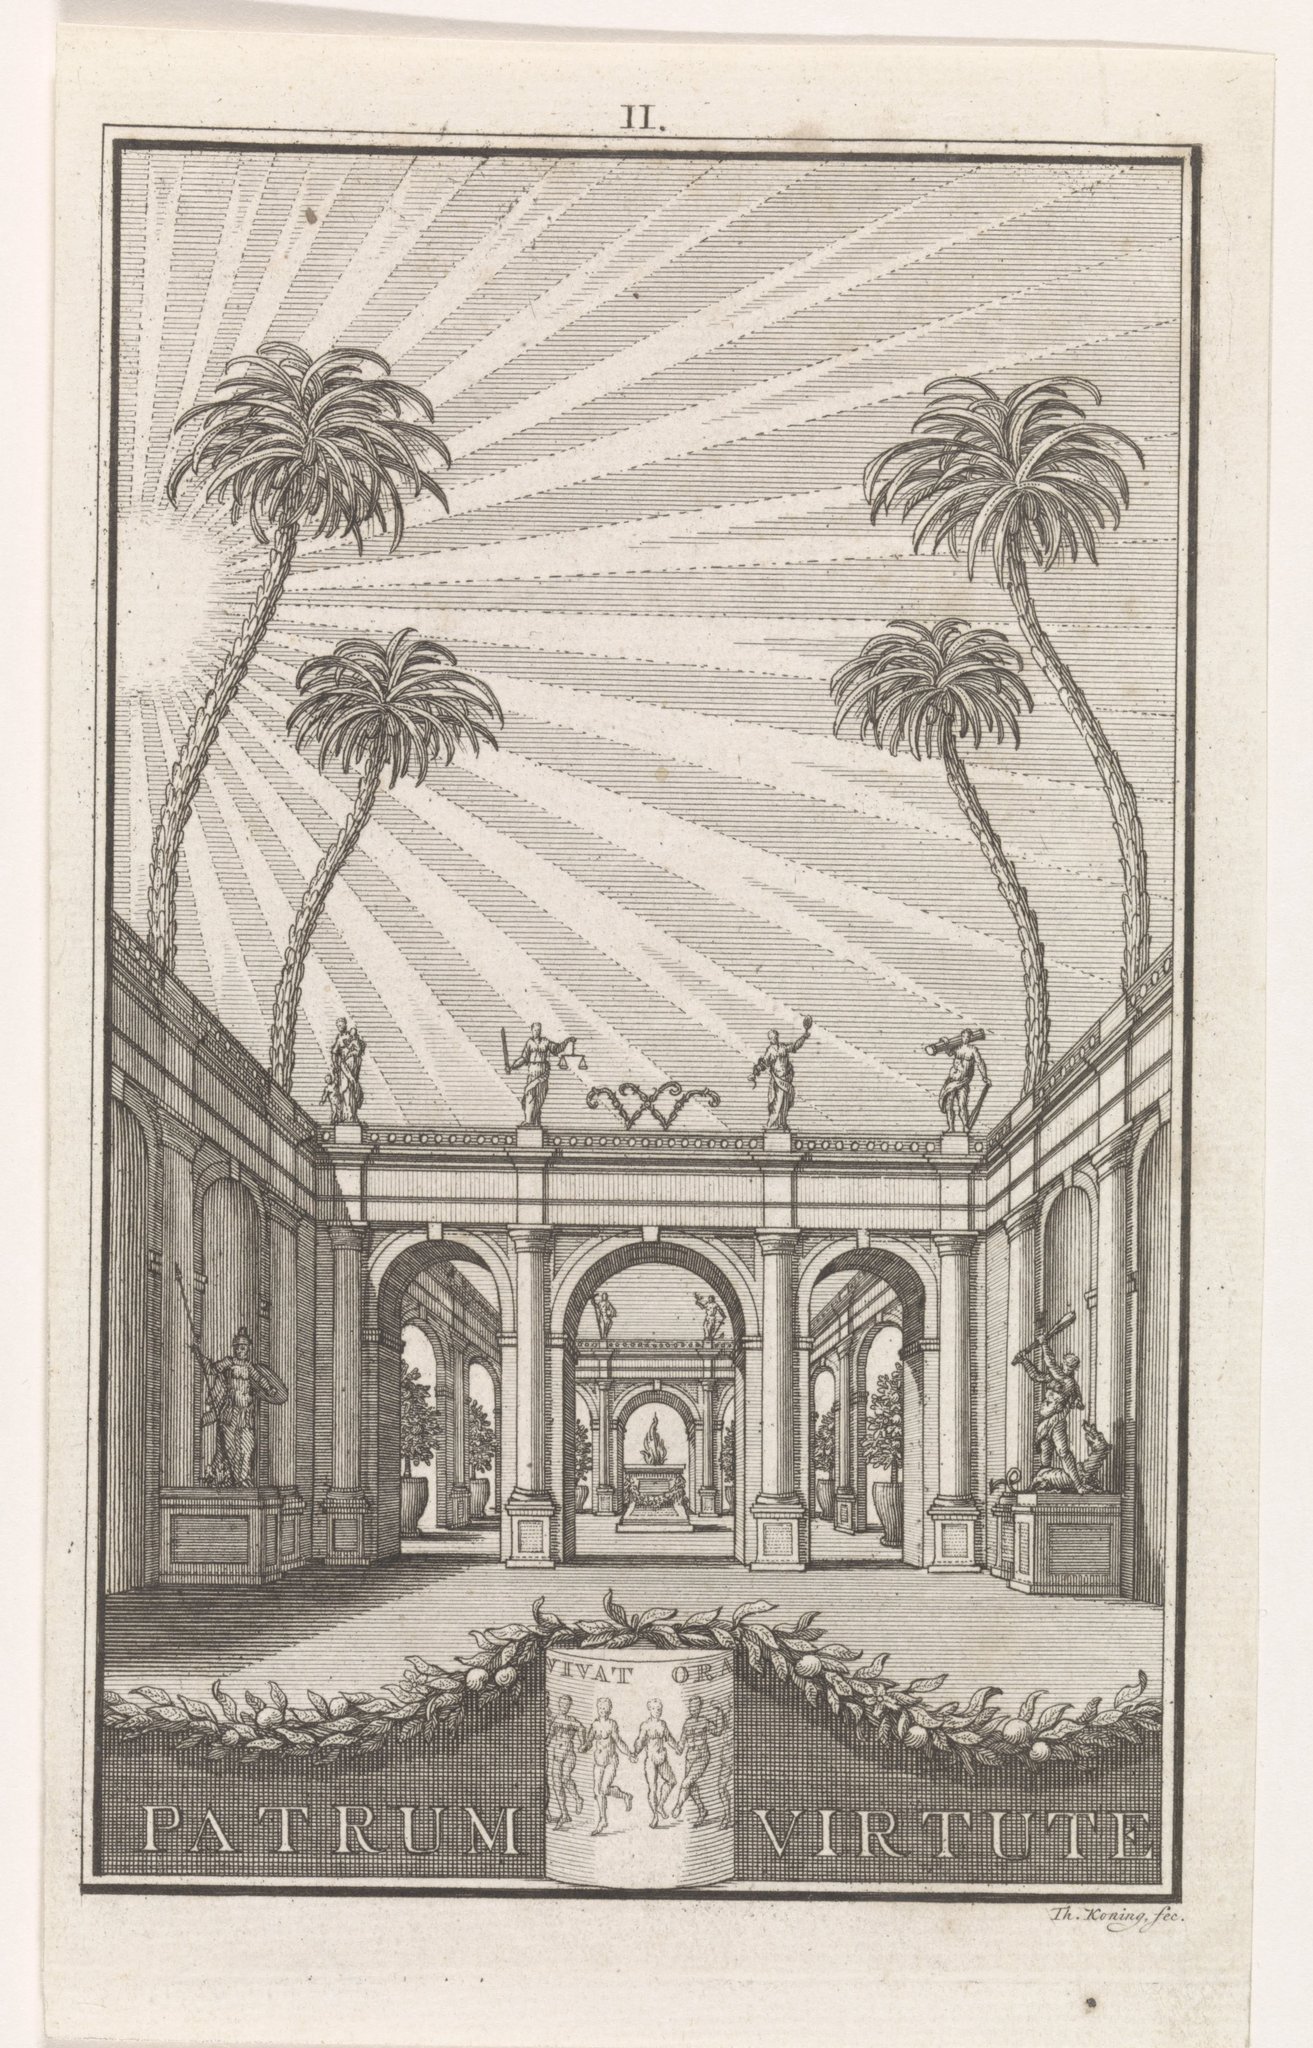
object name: print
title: Patrum Virtute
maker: theodoor koning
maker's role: print maker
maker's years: 1748-1829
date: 1758-1829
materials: paper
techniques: engraving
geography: amsterdam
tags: justitia (justice) as roman personification, courtyard, trees: palm-tree, sunlight, prudentia (prudence) as roman personification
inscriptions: collector's mark: Lugt 2228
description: Gezicht op een binnenplaats met in het midden drie bogen, rustende op zuilen. Op de bogen staan vier beelden, in het midden personificaties van Rechtvaardigheid en van Wijsheid. Achter de bogen een offerplaats waar een vuur brandt. Bij de omheining rechts en links een beeld op een verhoging. Boven de muur steken palmbomen uit. Onder de afbeelding de titel.